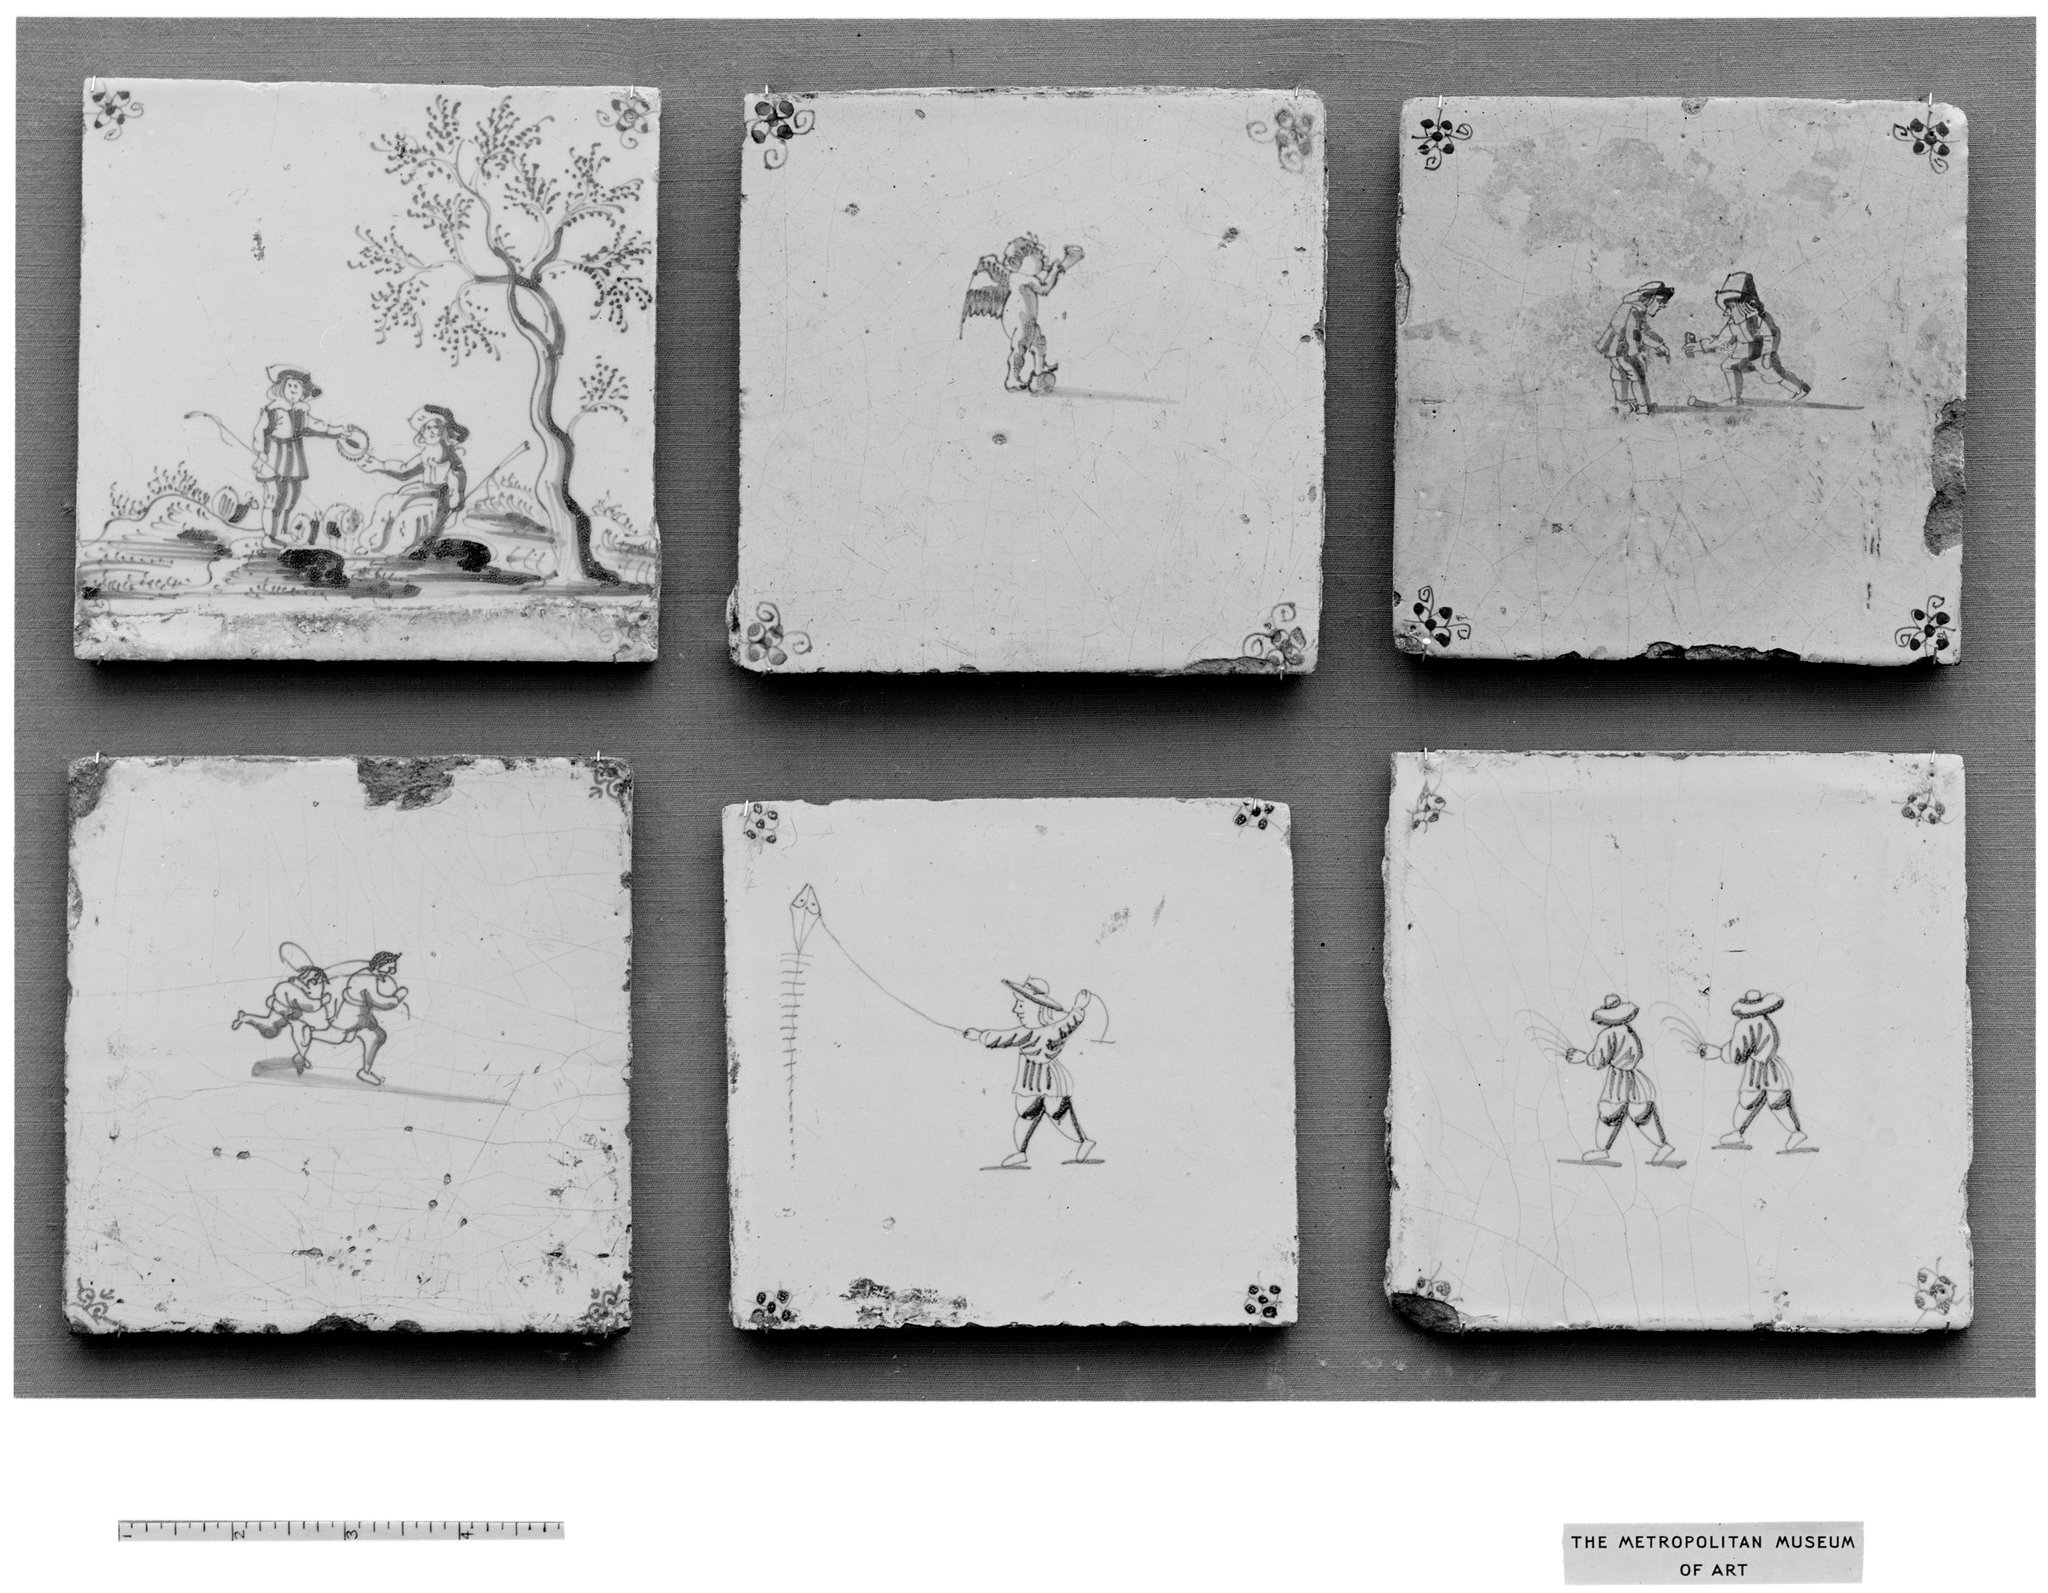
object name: tile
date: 1701-1800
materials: earthenware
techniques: glazing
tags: men,women,trees